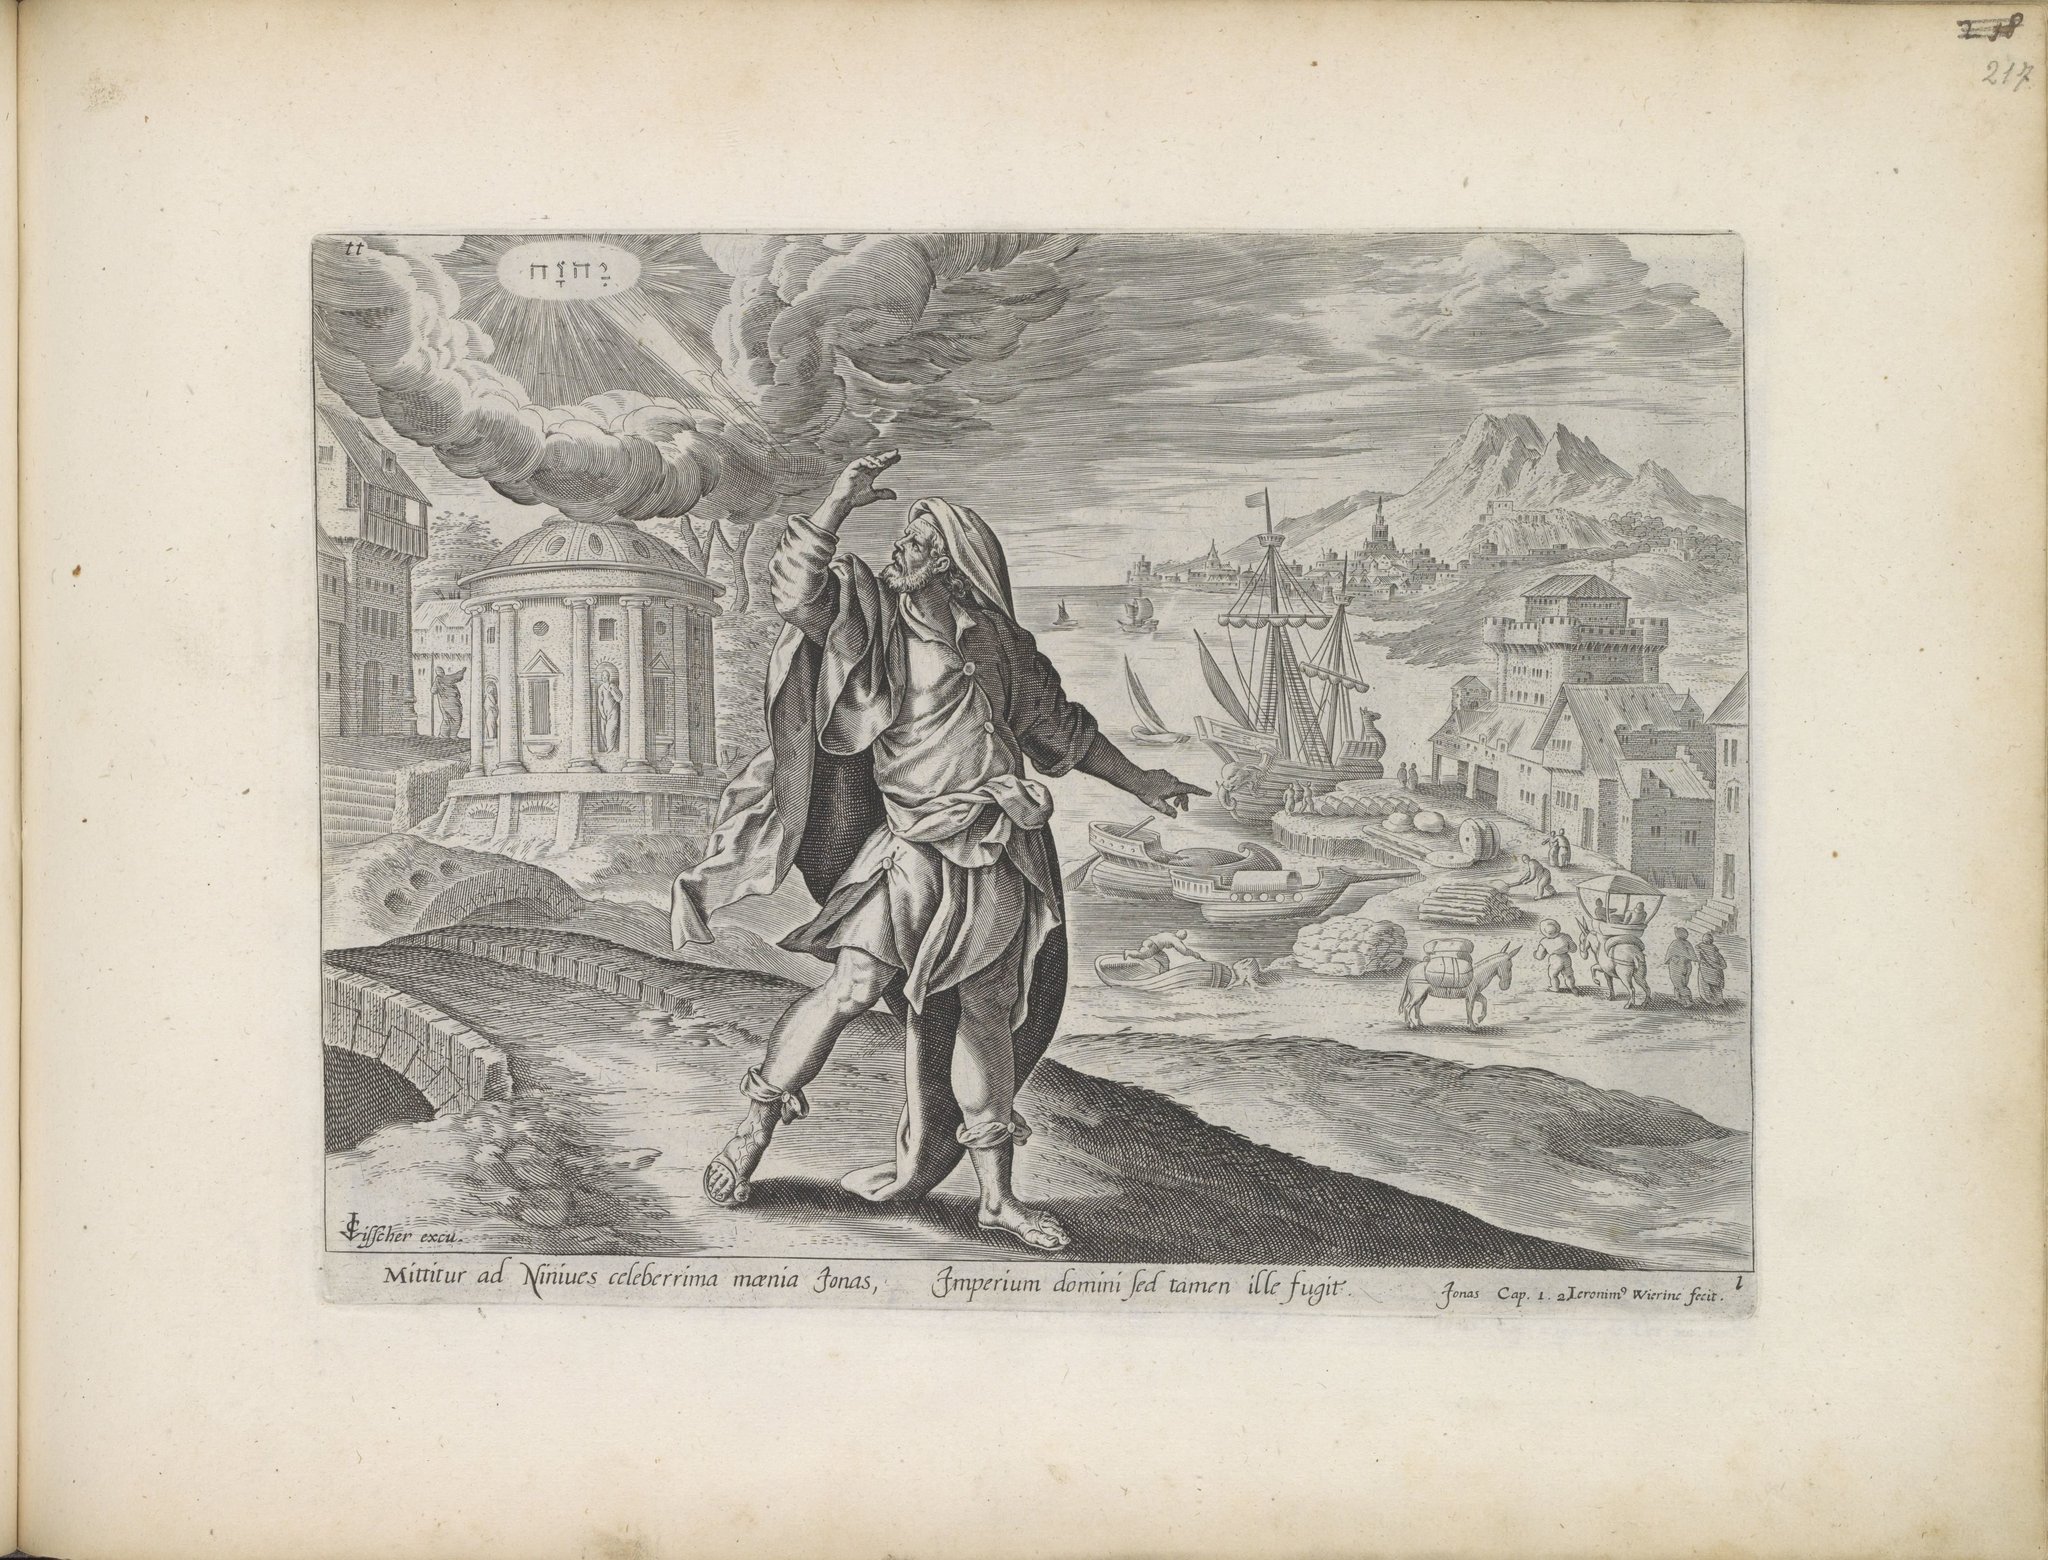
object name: print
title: Theatrum Biblicum Hoc Est Historiae Sacrae Veteris et Novi Testamenti Tabulis Aeneis Expressae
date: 1585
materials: paper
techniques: engraving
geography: amsterdam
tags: to escape the assigned task by god jonah boards a ship about to go to tarshish, jonah's call and disobedience (jonah 1), jonah is sent by god to nineveh to preach to its sinful citizens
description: Jona wordt door God de Vader naar de stad Nineve gestuurd. Jona wil niet en vlucht met een schip naar Tarsis. Jona wijst al op het schip dat hij zal nemen. Onder de voorstelling een verwijzing in het Latijn naar de Bijbeltekst in Jona 1:2. Deze prent maakt deel uit van een album.